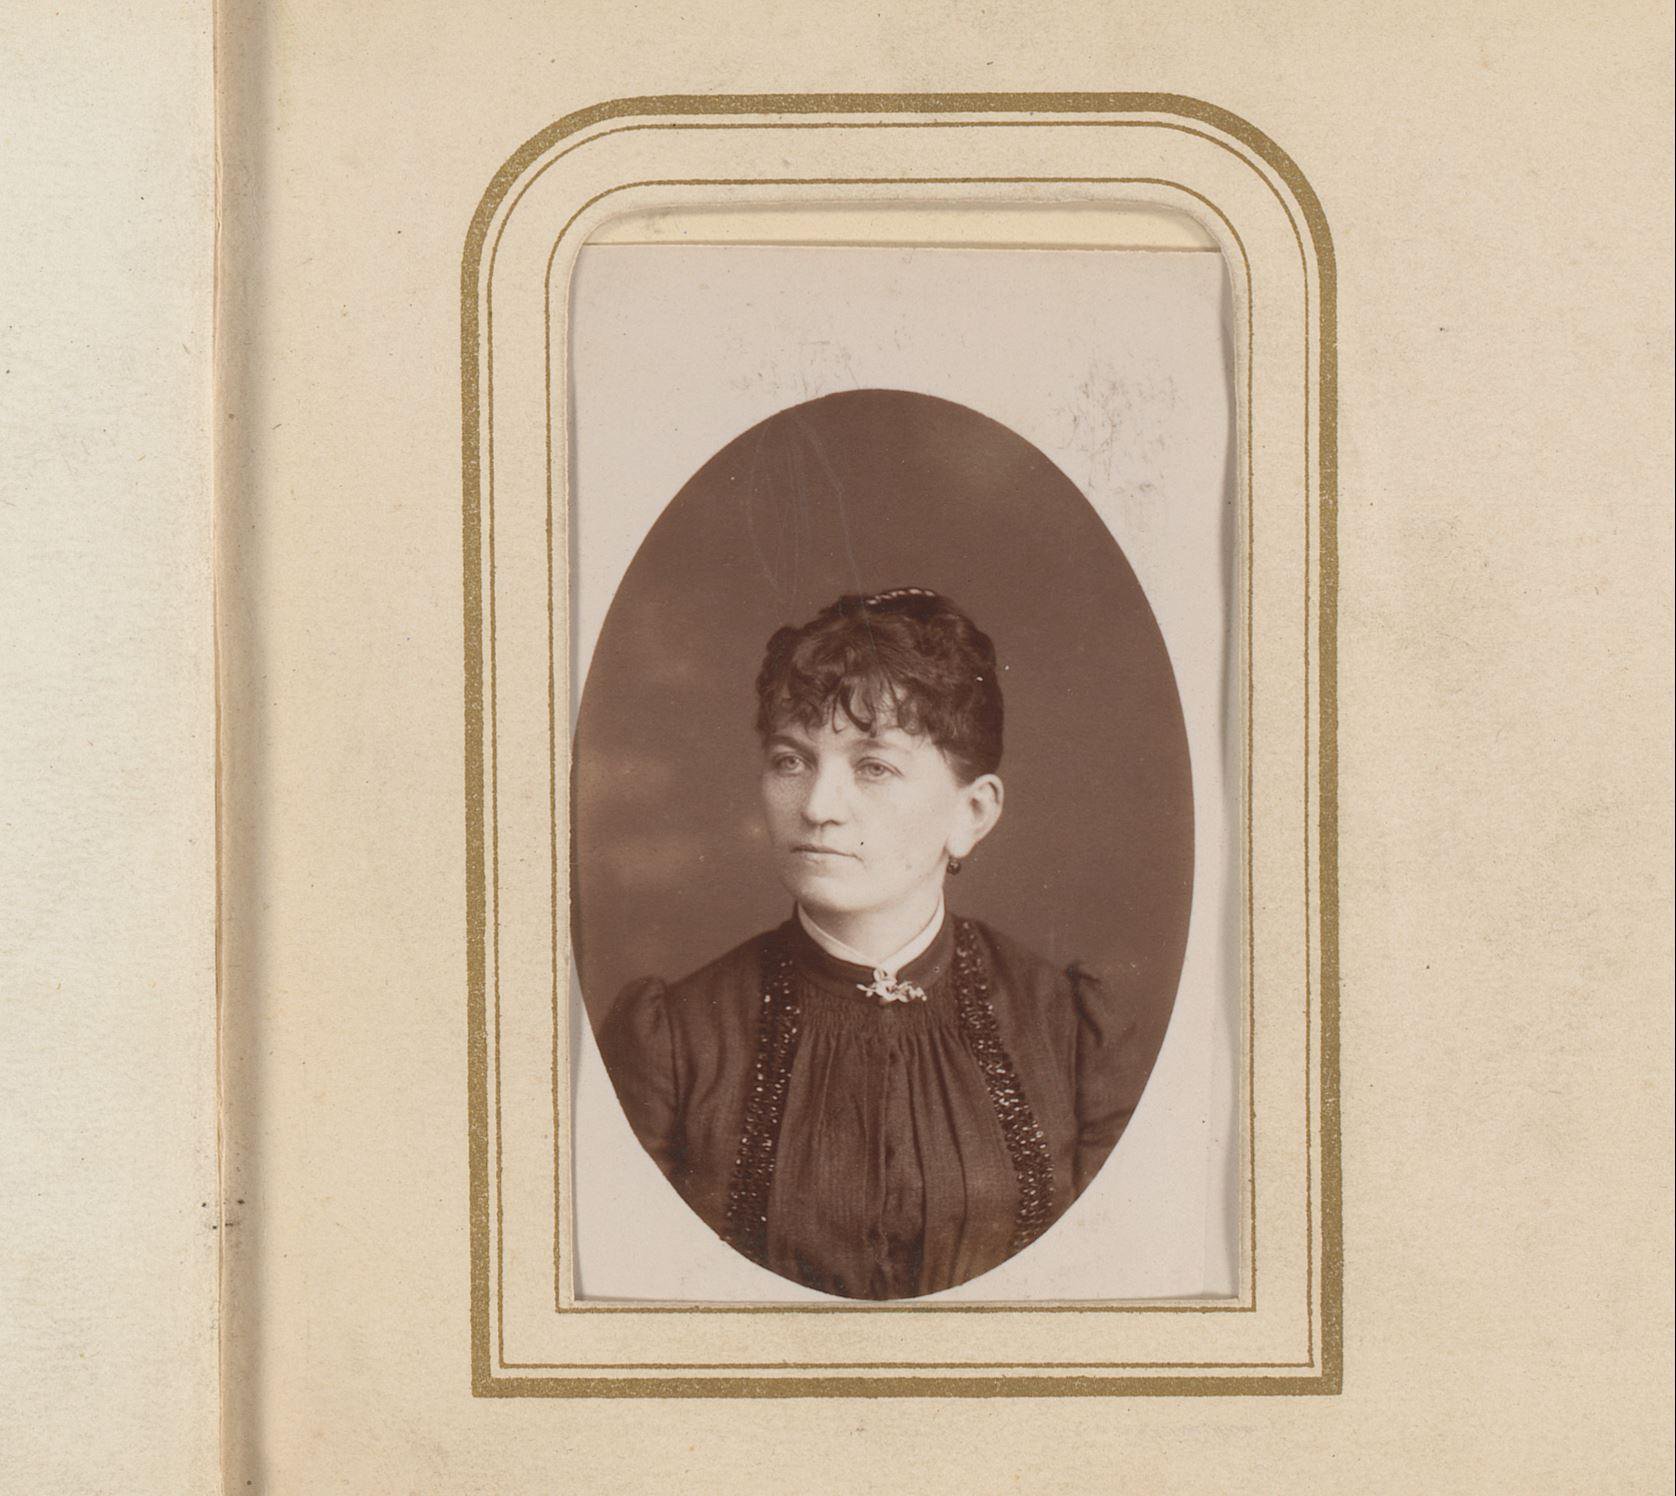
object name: album leaf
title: Portret van een vrouw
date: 1860-1900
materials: cardboard, photographic support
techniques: albumen print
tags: adult woman, historical persons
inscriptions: inscription: ‘Phototgraphie de l'Hotel de Ville/ L. Muller-Rault/ 48 Bis/ Rue de Rivoli/ Paris’